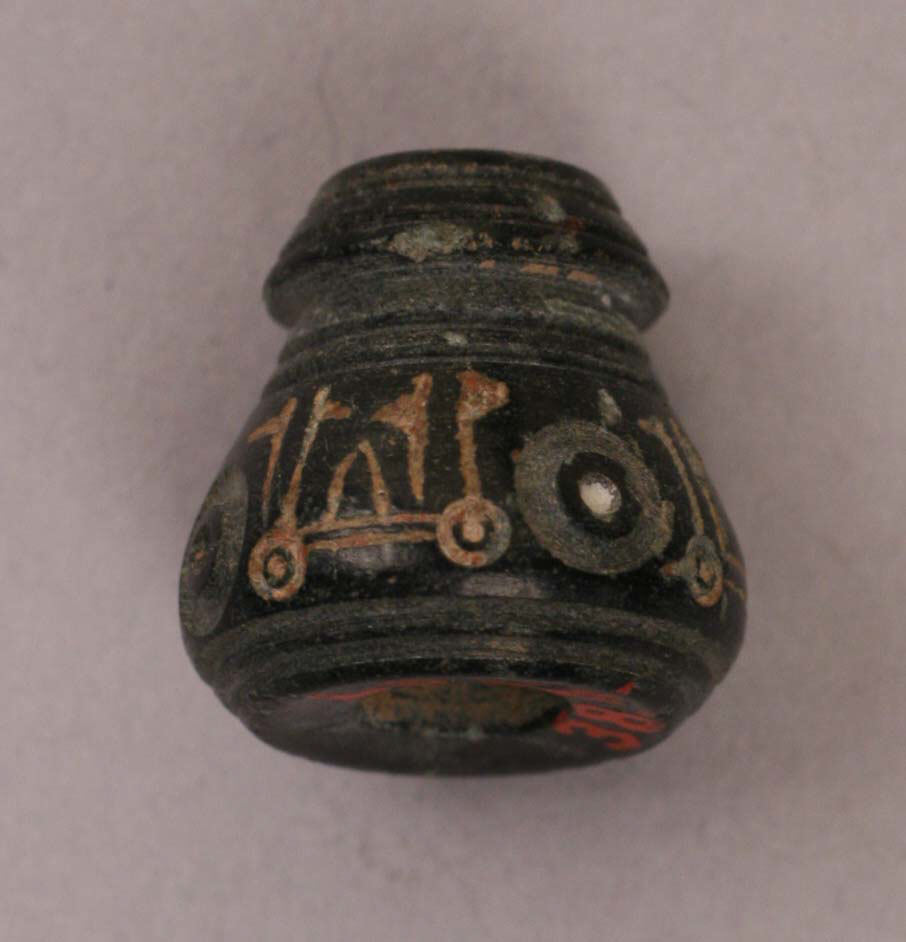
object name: button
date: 701-1000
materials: paint, stone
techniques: incising, inlay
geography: iran